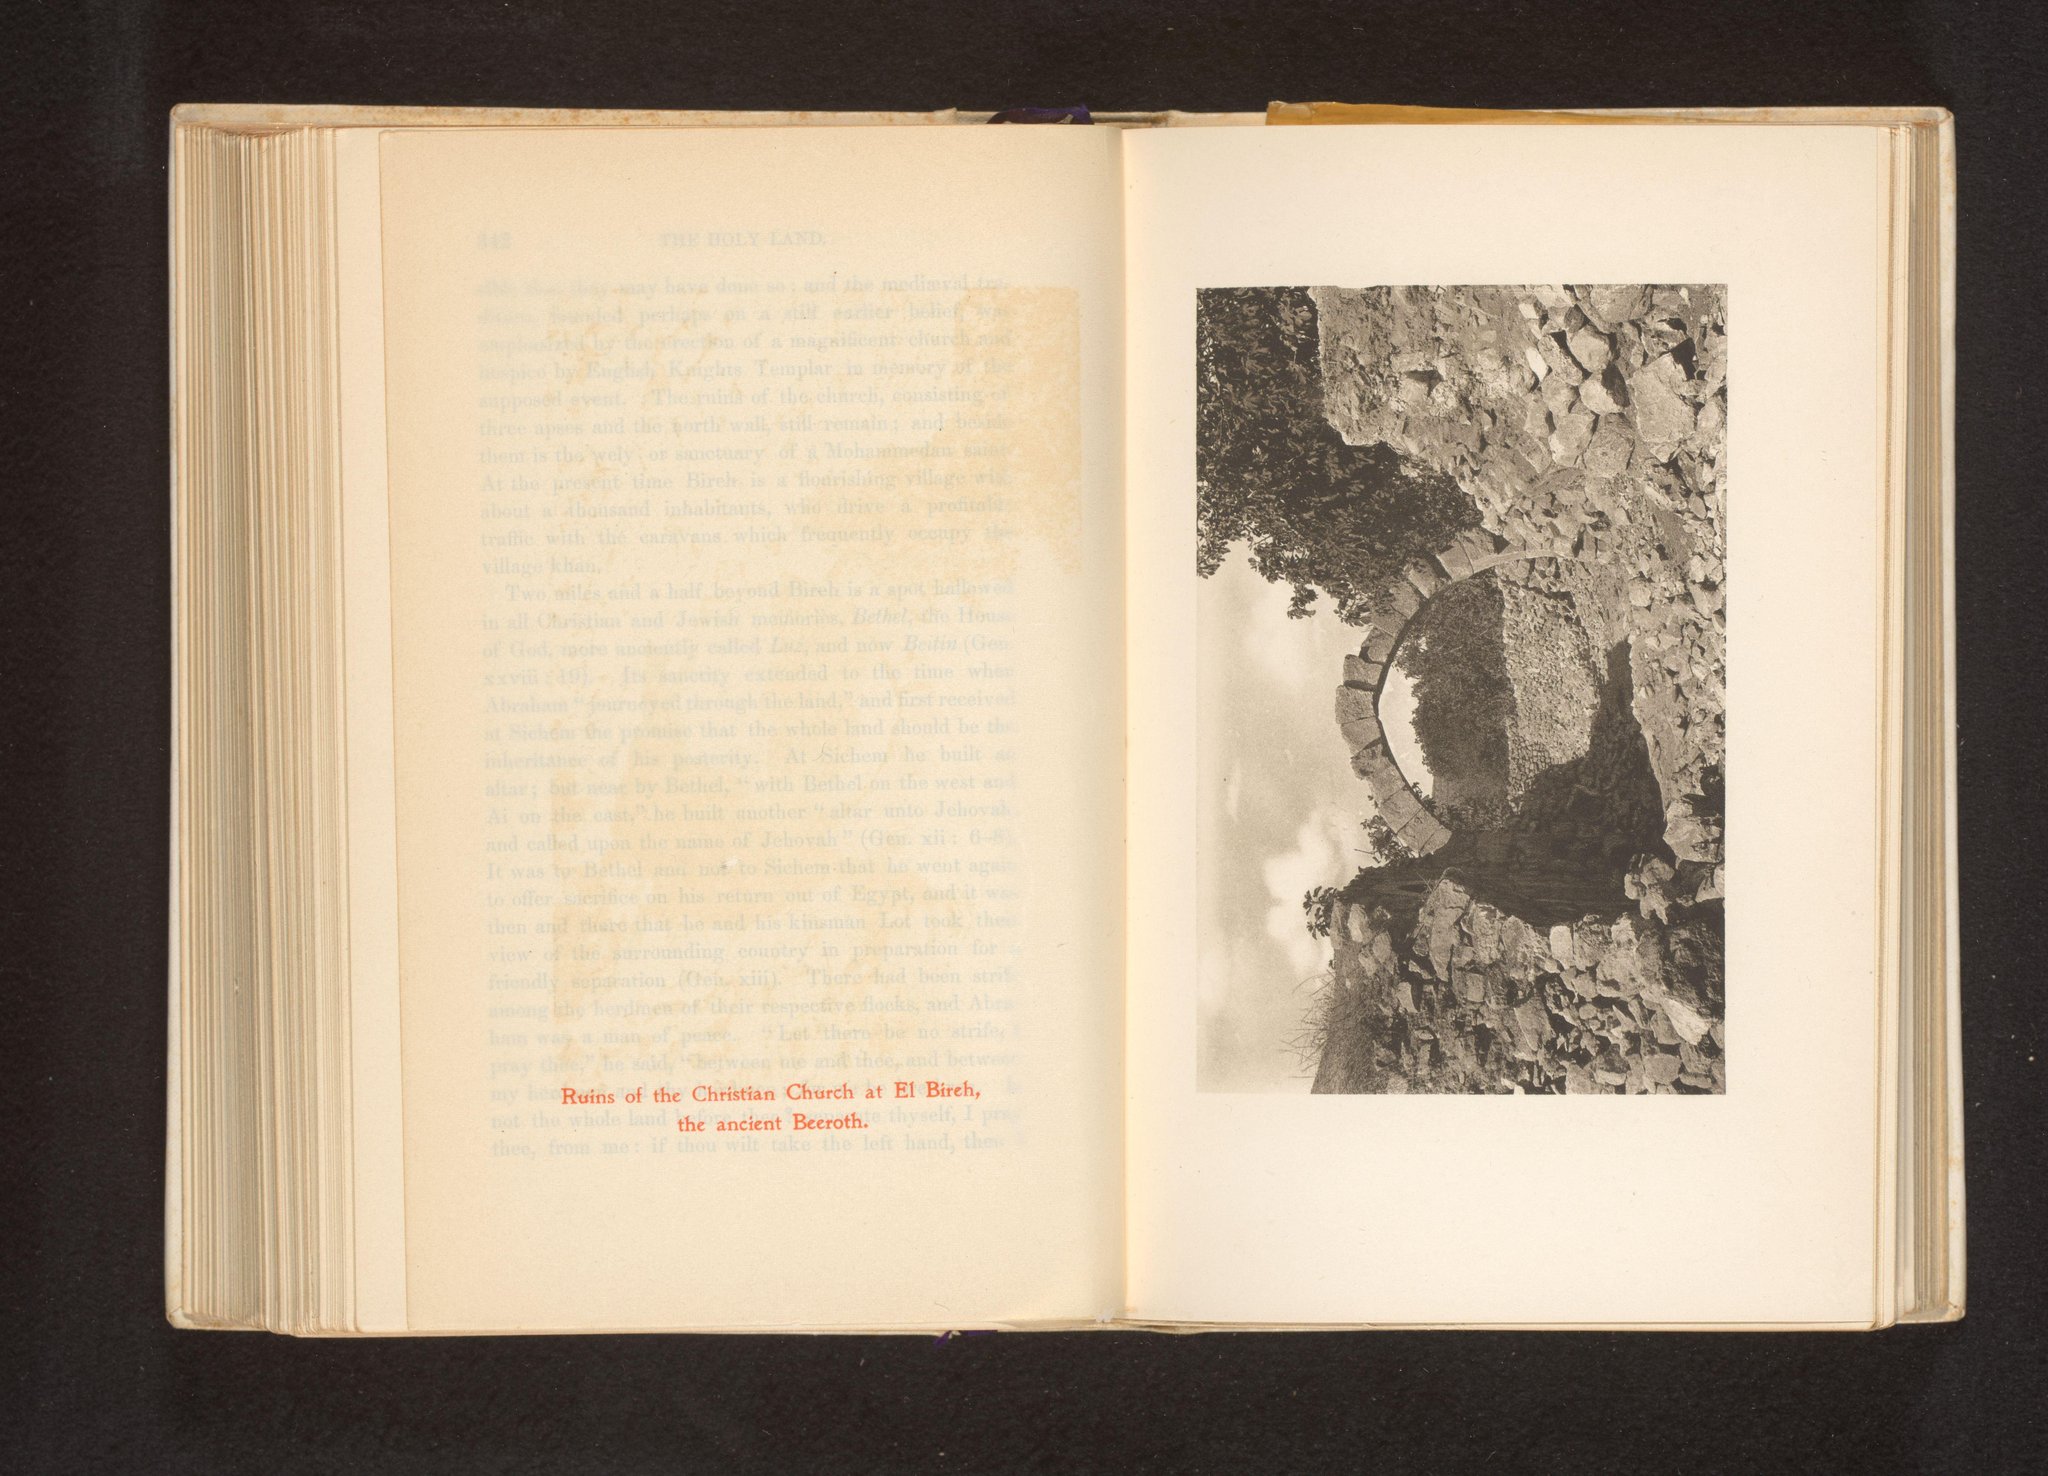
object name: page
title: Ruïne van een kerk te Al-Bireh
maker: Anonymous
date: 1890-1900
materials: paper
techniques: photoaquatint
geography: al-bireh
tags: ruin of a building ~ architecture, church (exterior)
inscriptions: title: ‘Ruins of the Christian Church at El Bireh, the ancient Beeroth.’